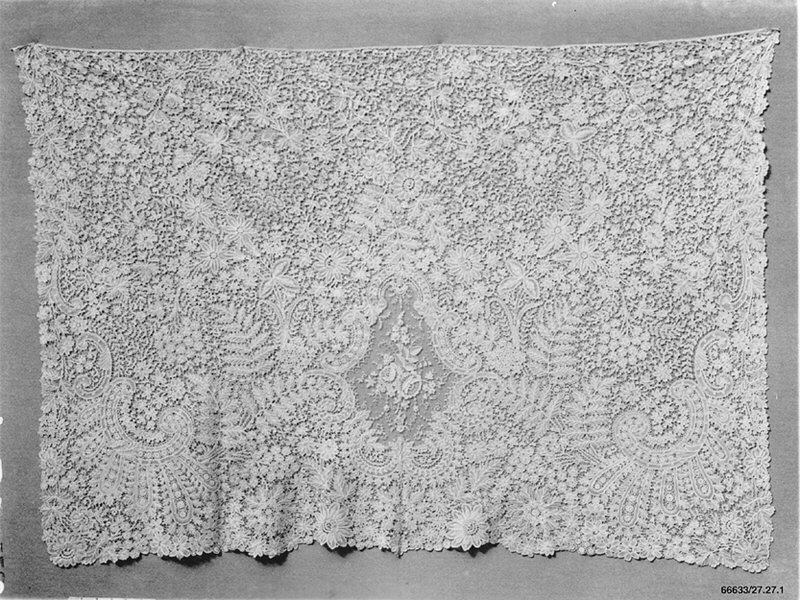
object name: panel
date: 1834-1866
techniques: lace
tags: flowers,leaves